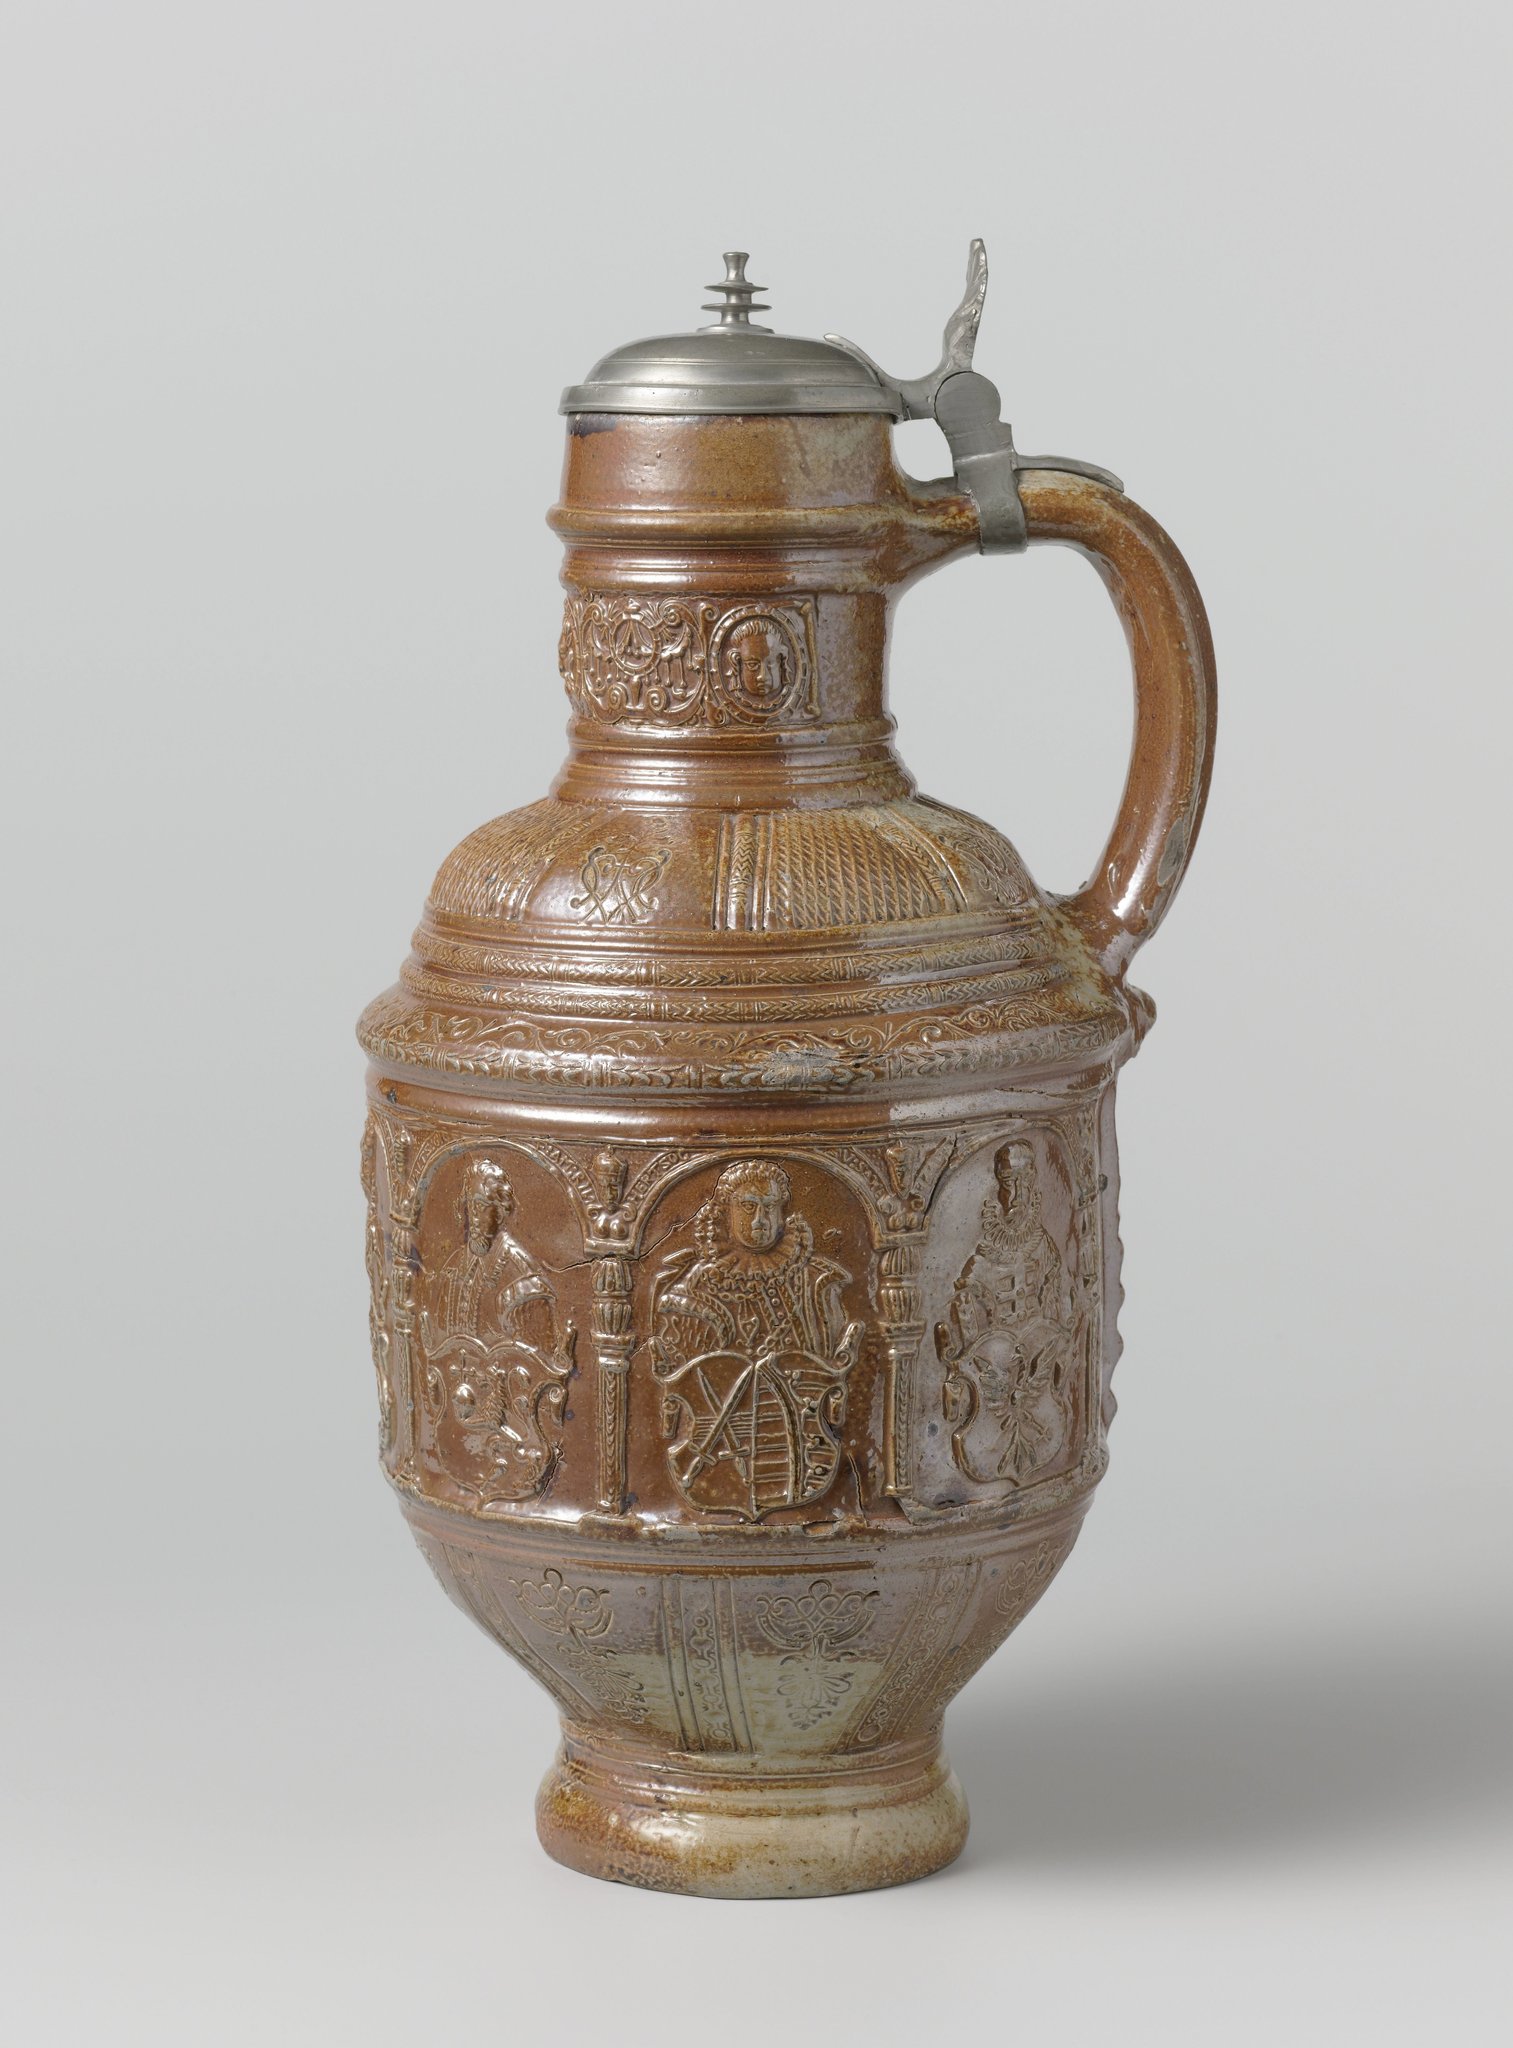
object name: jug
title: Jug with seven Electors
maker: Anonymous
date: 1602-1610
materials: engobe, glaze, stoneware, tin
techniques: printing, firing, forming, relief, turning, vitrification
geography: raeren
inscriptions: date: ‘1602’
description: Kruik van steengoed op hoge voet met een cilindrisch lichaam, ronde schouder en wijde nek. Profielen op de nek, het lichaam en de voet. Bedekt met een bruine engobe. Op de buik in reliëf een gedrukte en opgelegde band met bogen. Onder elke boog is een keurvorst met zijn respectievelijke wapen afgebeeld (de aartsbisschoppen van Trier, Keulen en Mainz, de koning van Bohemen, de markgraaf van Brandenburg, Palzgraaf en de hertog van Saksen), met in de boog zijn titel. In het meest linker vak de datum '1602'. Het onderste deel van de buik loopt schuin af naar de voet en heeft ingegrifte vakken met gestempelde bloemranken. Op de schouder afwisselend kerfsnede en een gestempelde bloem in de vakken. De nek met een band maskers in medaillons, afgewisseld met rolwerk. Bevestigd aan het oor een tinnen montuur met deksel. Raeren.